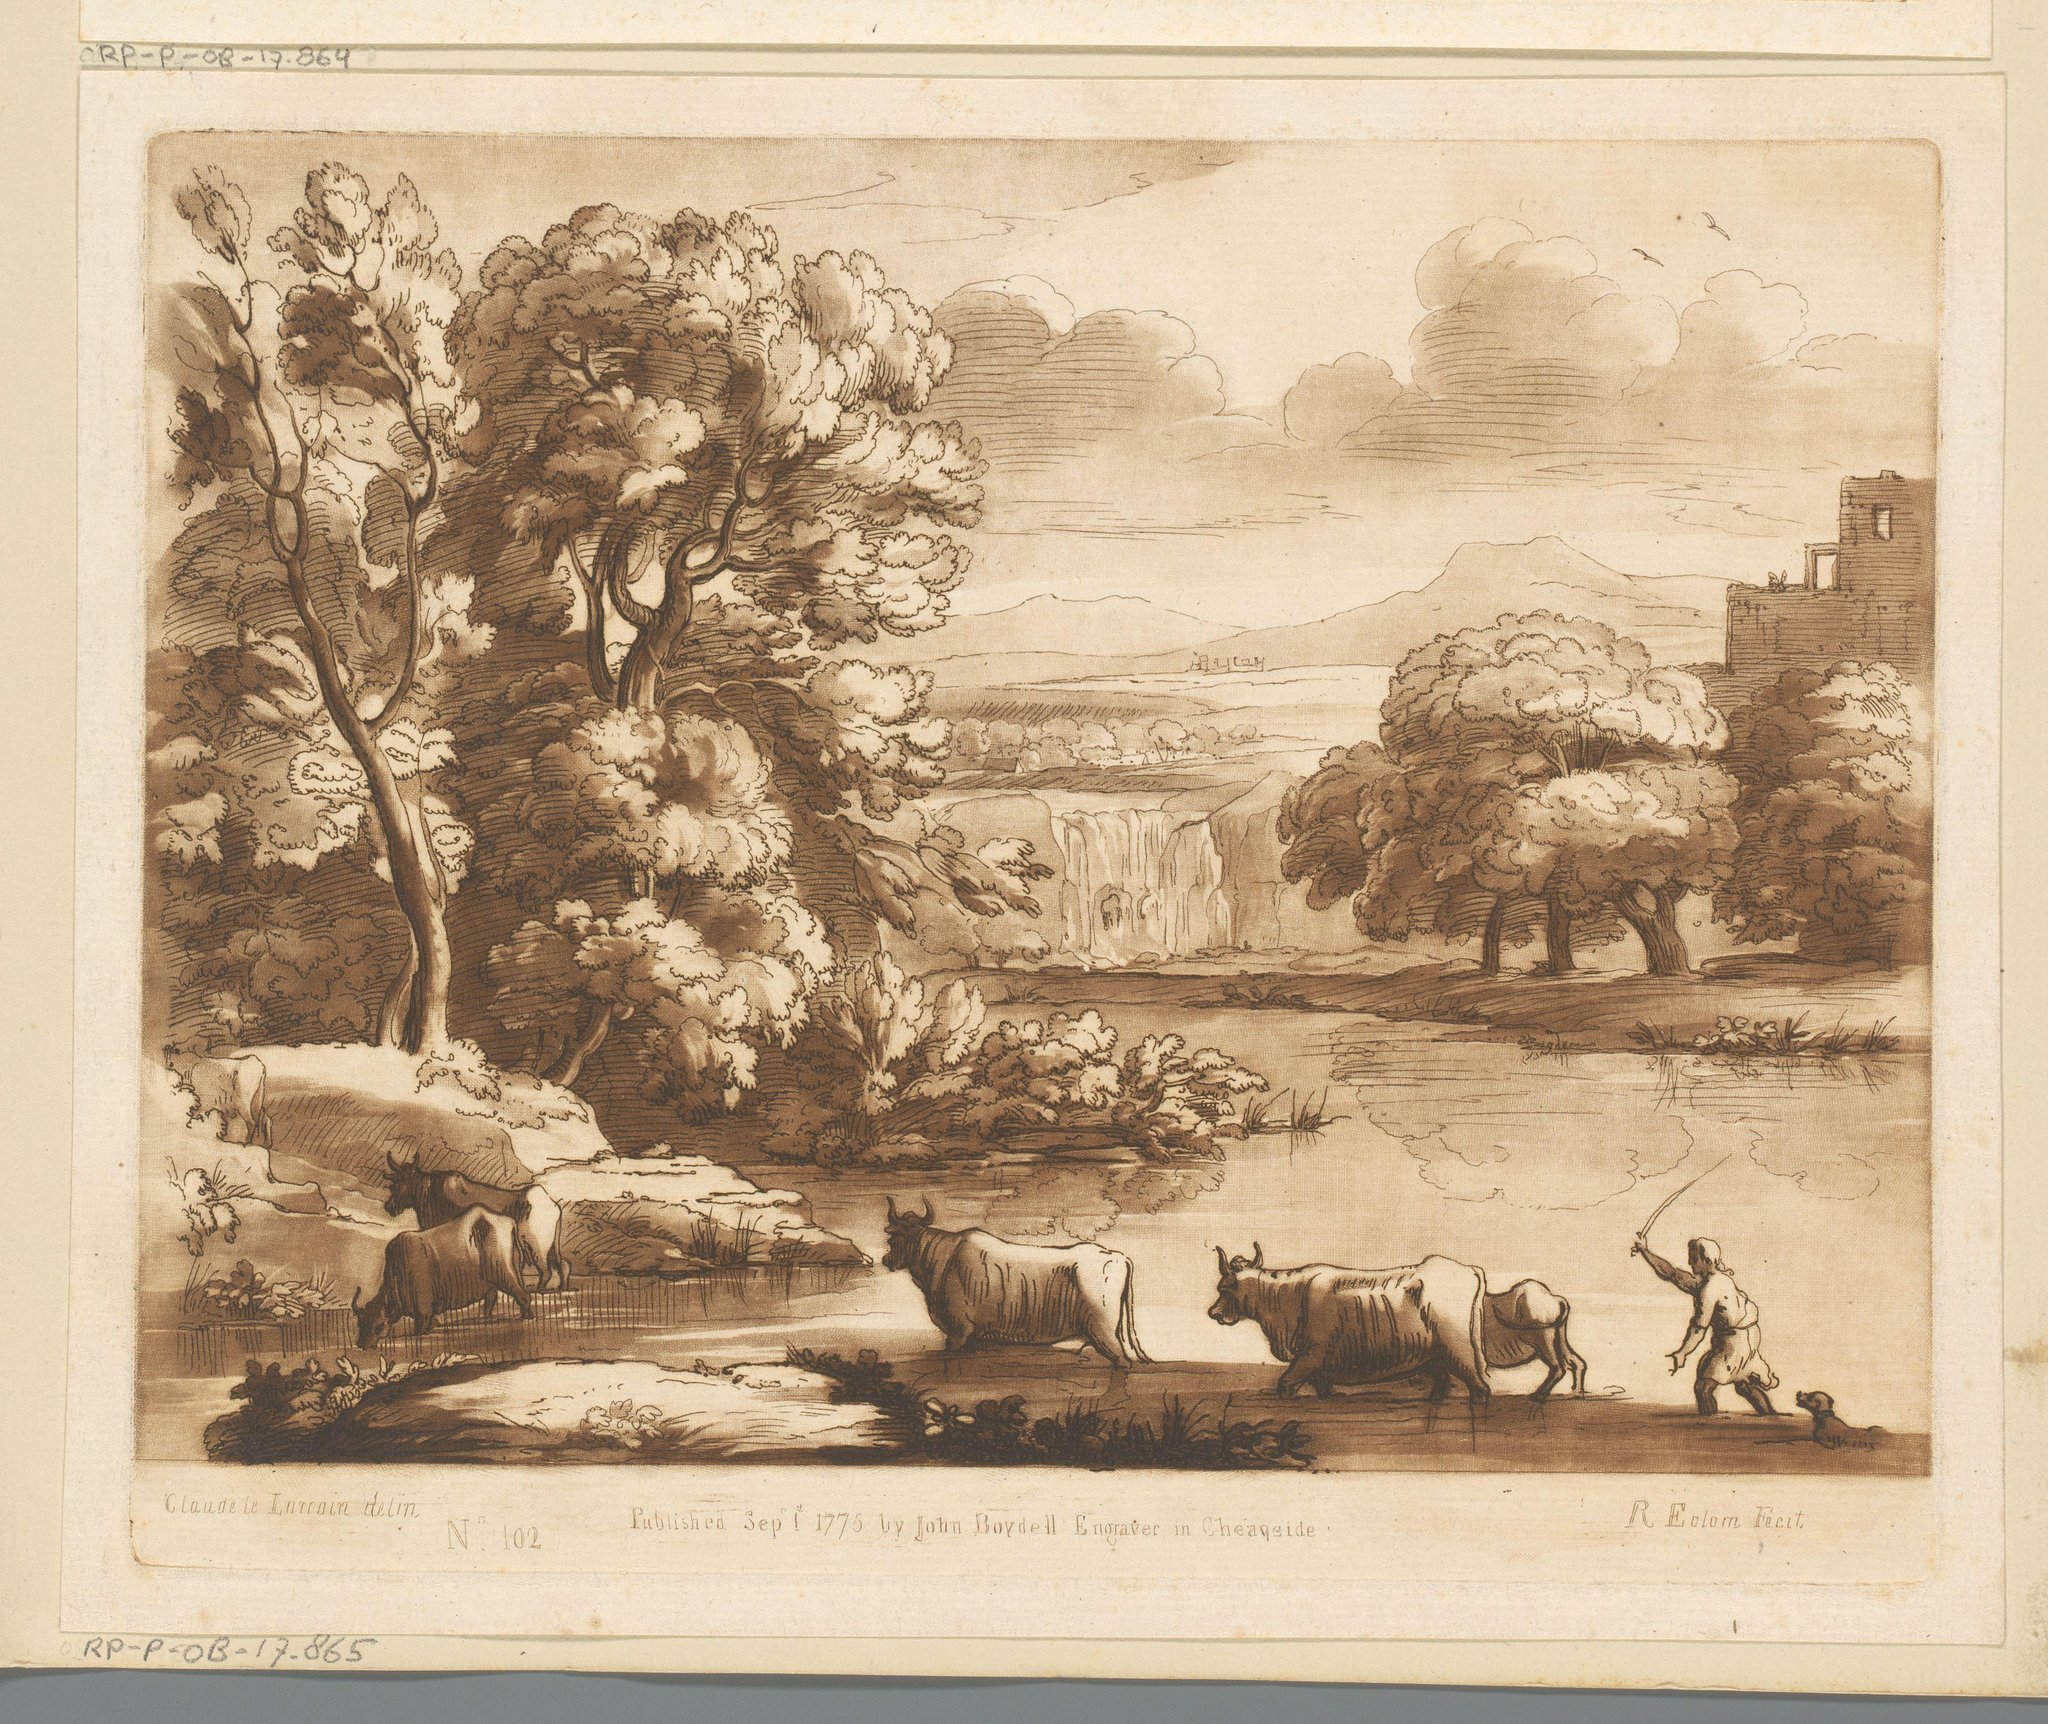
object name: print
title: Prenten naar tekeningen van Claude Lorrain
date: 1775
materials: paper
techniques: etching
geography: london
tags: crossing a river, waterfall - hh - ideal landscapes, cattle driving, cattle driver, landscape with ruins - ii - ideal landscapes, pastorals, arcadian scenes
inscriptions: date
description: Vanaf 1774 publiceerde John Boydell tweehonderd prenten naar het tekeningenboek Liber Veritatis van Claude Lorrain, in het bezit van de hertogen van Cavendish. Deze prenten werden vanaf 1777 in twee volumes gebundeld uitgegeven.